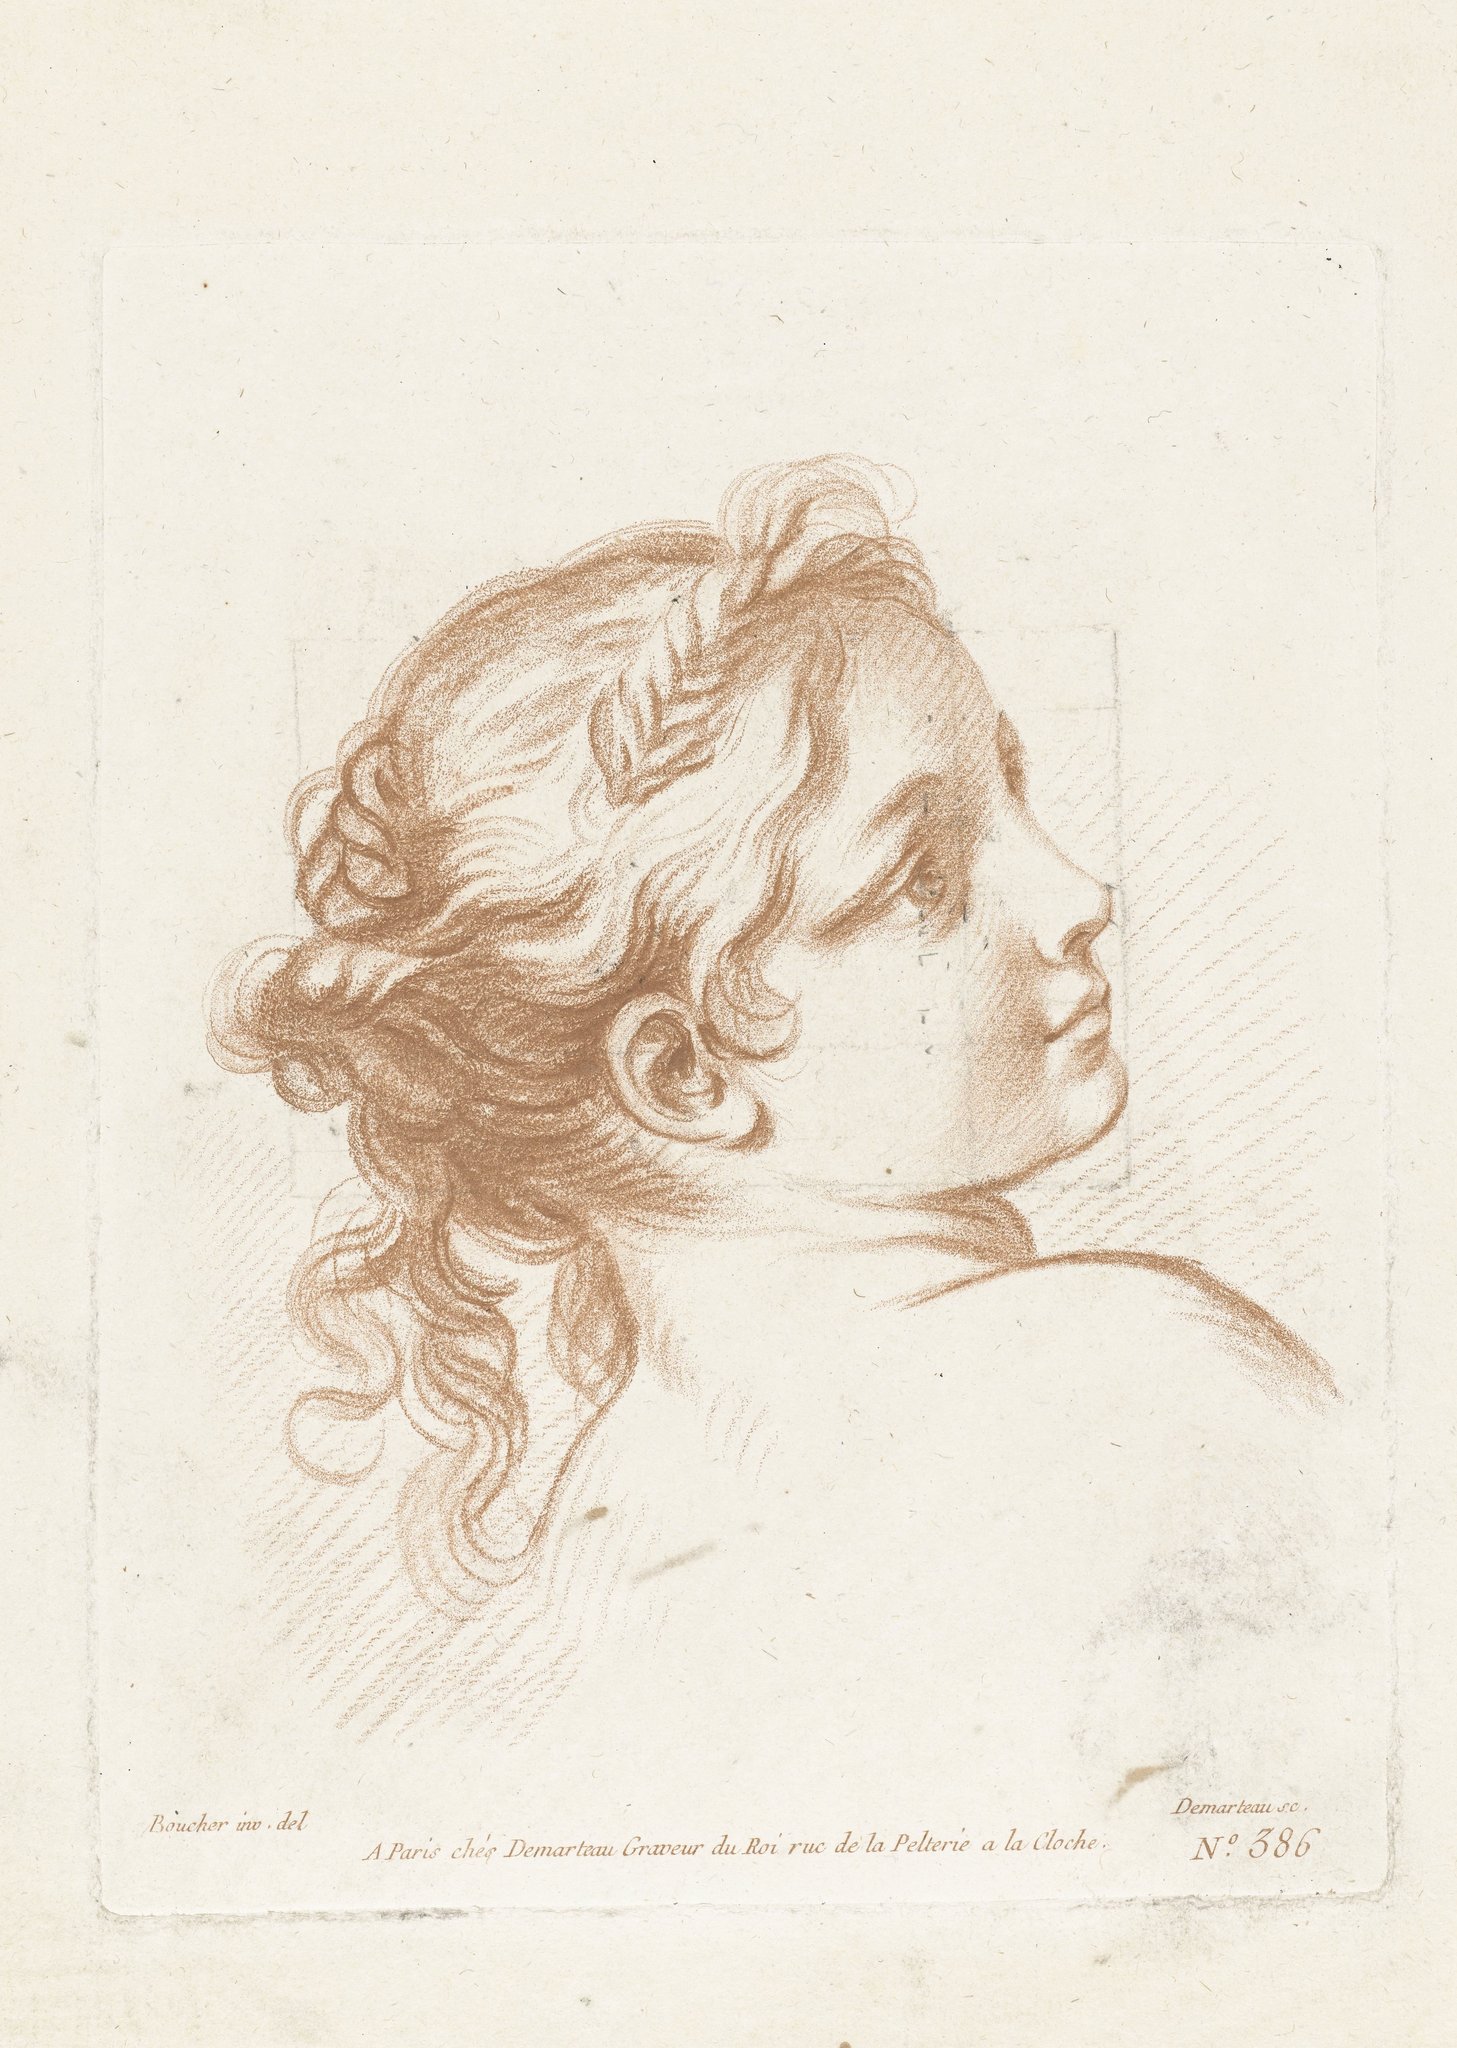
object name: print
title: Buste van een jonge vrouw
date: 1756-1776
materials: paper, pencil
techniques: printmaking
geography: paris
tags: head (human) - aa - female human figure (+ sideview, profile)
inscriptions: number: ‘No. 386’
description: Buste van een jonge vrouw, kijkend over haar schouder naar rechts. Met potlood zijn er lijnen gezet die de verhoudingen in het gezicht aangeven.